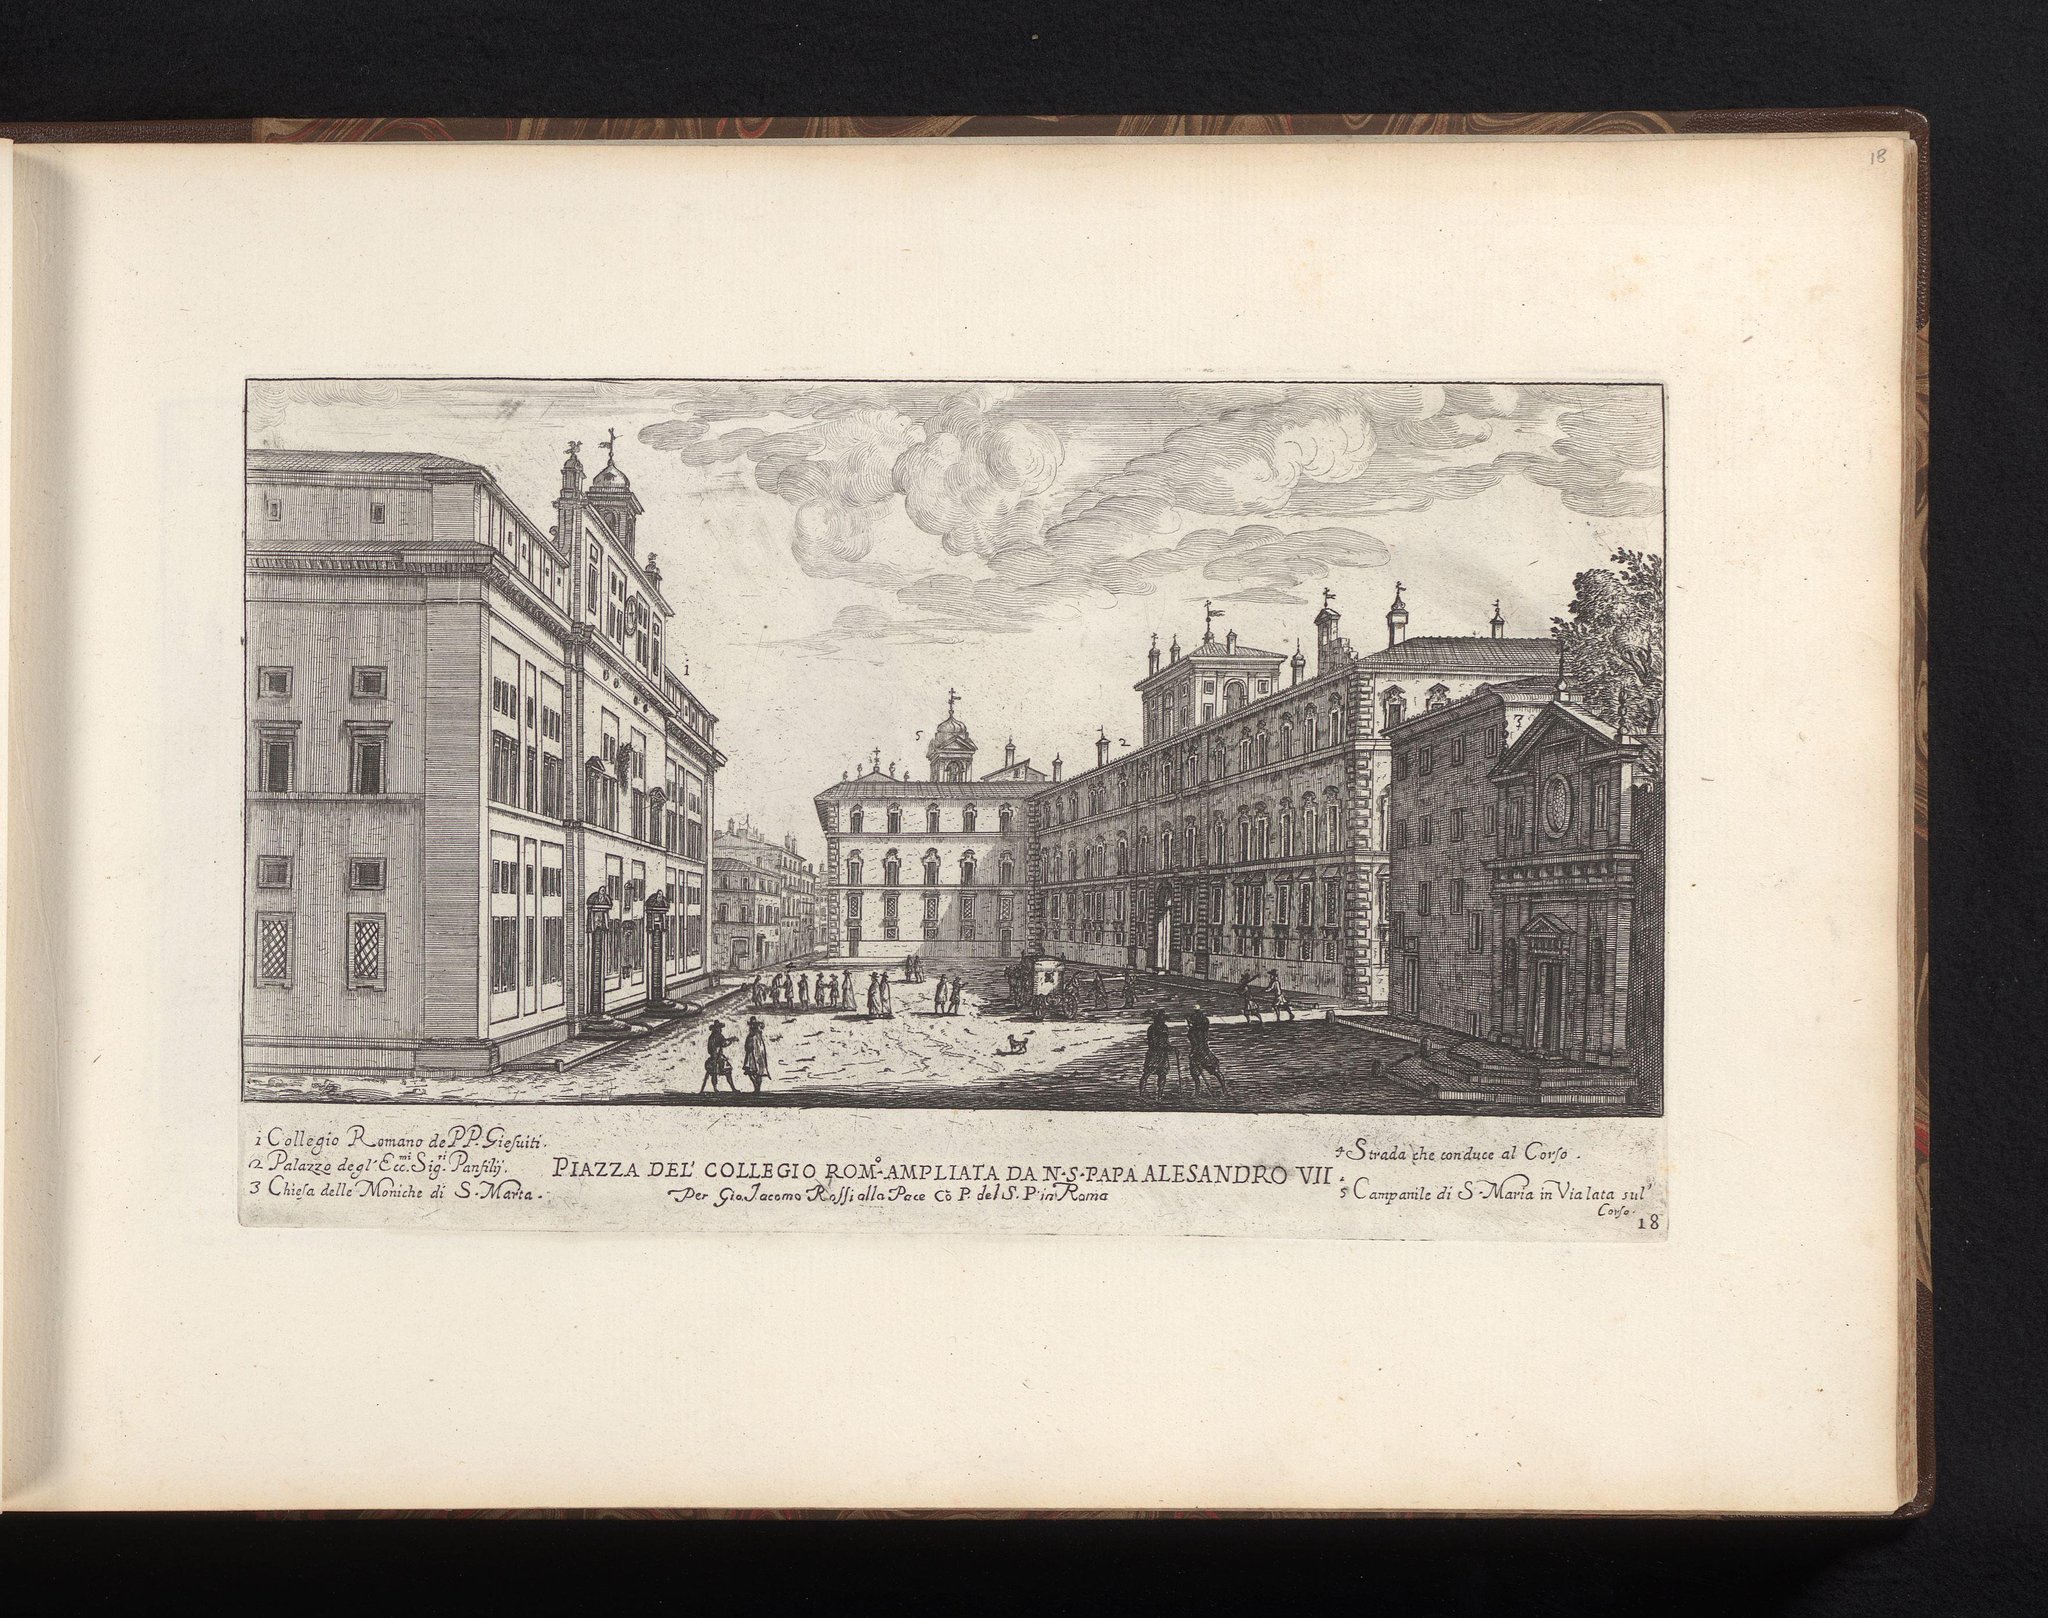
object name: album leaf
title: Piazza del' Collegio Rom.o apliata da N.S. papa Alesandro VII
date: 1665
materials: paper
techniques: etching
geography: vatican city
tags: square, place, circus, etc., city-view, and landscape with man-made constructions, university building, college, façade (of house or building)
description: Deze prent maakt deel uit van een reeks van 35 prenten met voorstellingen van gebouwen in Rome. Samen met vier andere reeksen vormt het de grote reeks: 'Il nuovo teatro di Roma moderna'.